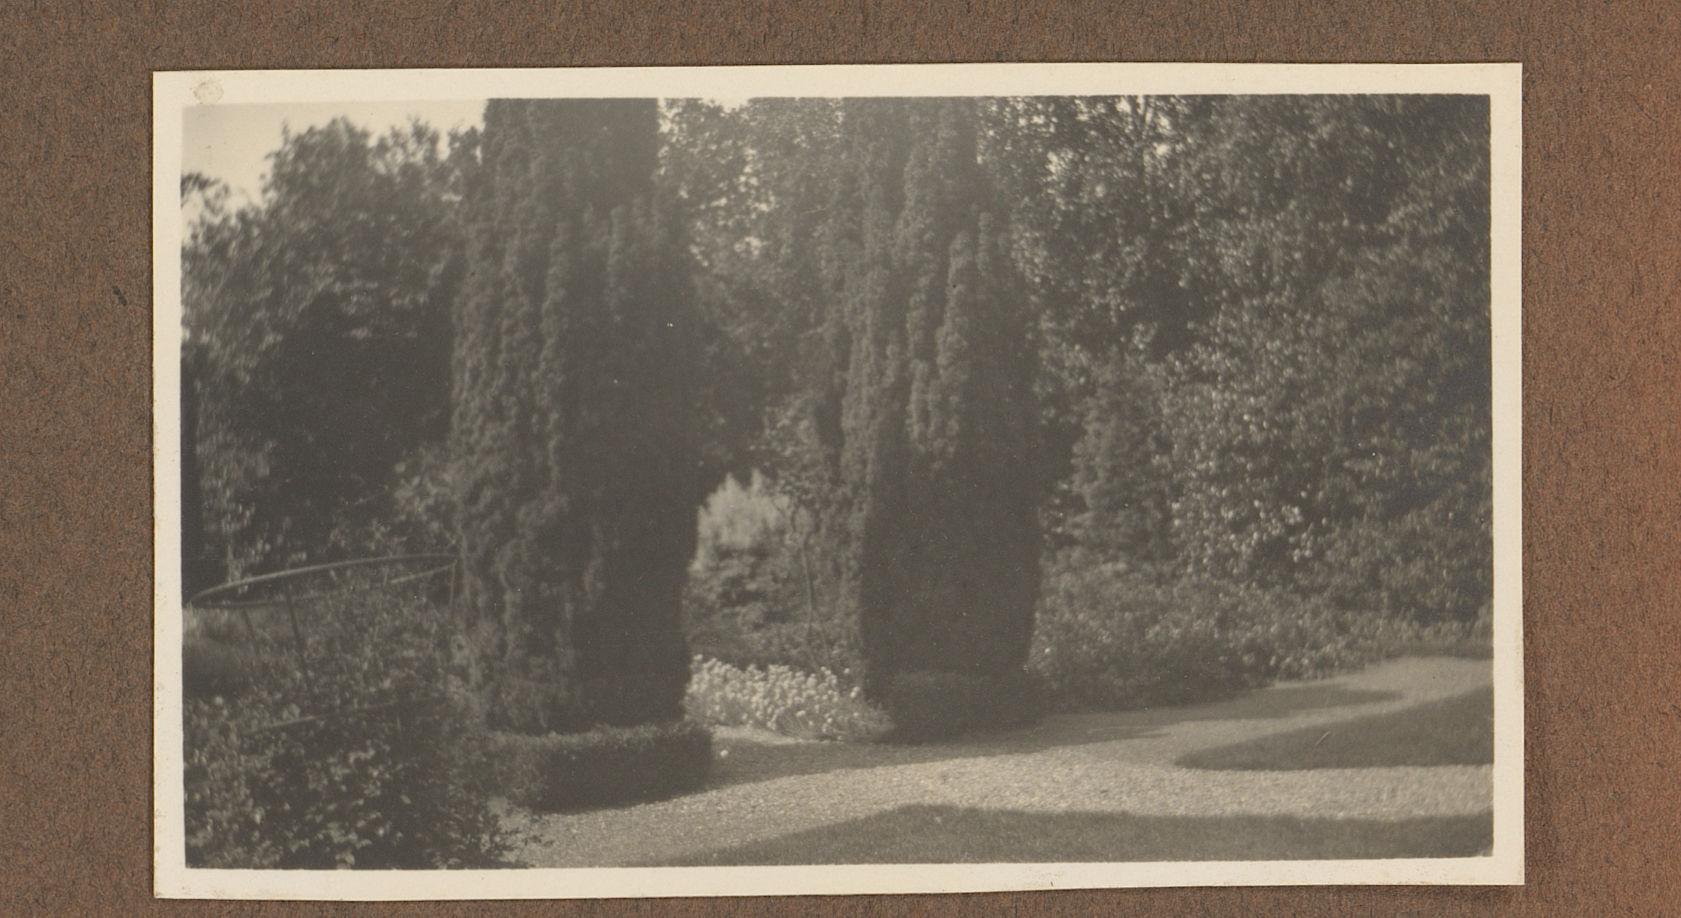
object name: photograph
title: Tuin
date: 1900-1920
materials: photographic support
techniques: photography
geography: amsterdam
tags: netherlands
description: Foto op bruin albumblad 57 van familiealbum van Alphons Diepenbrock.